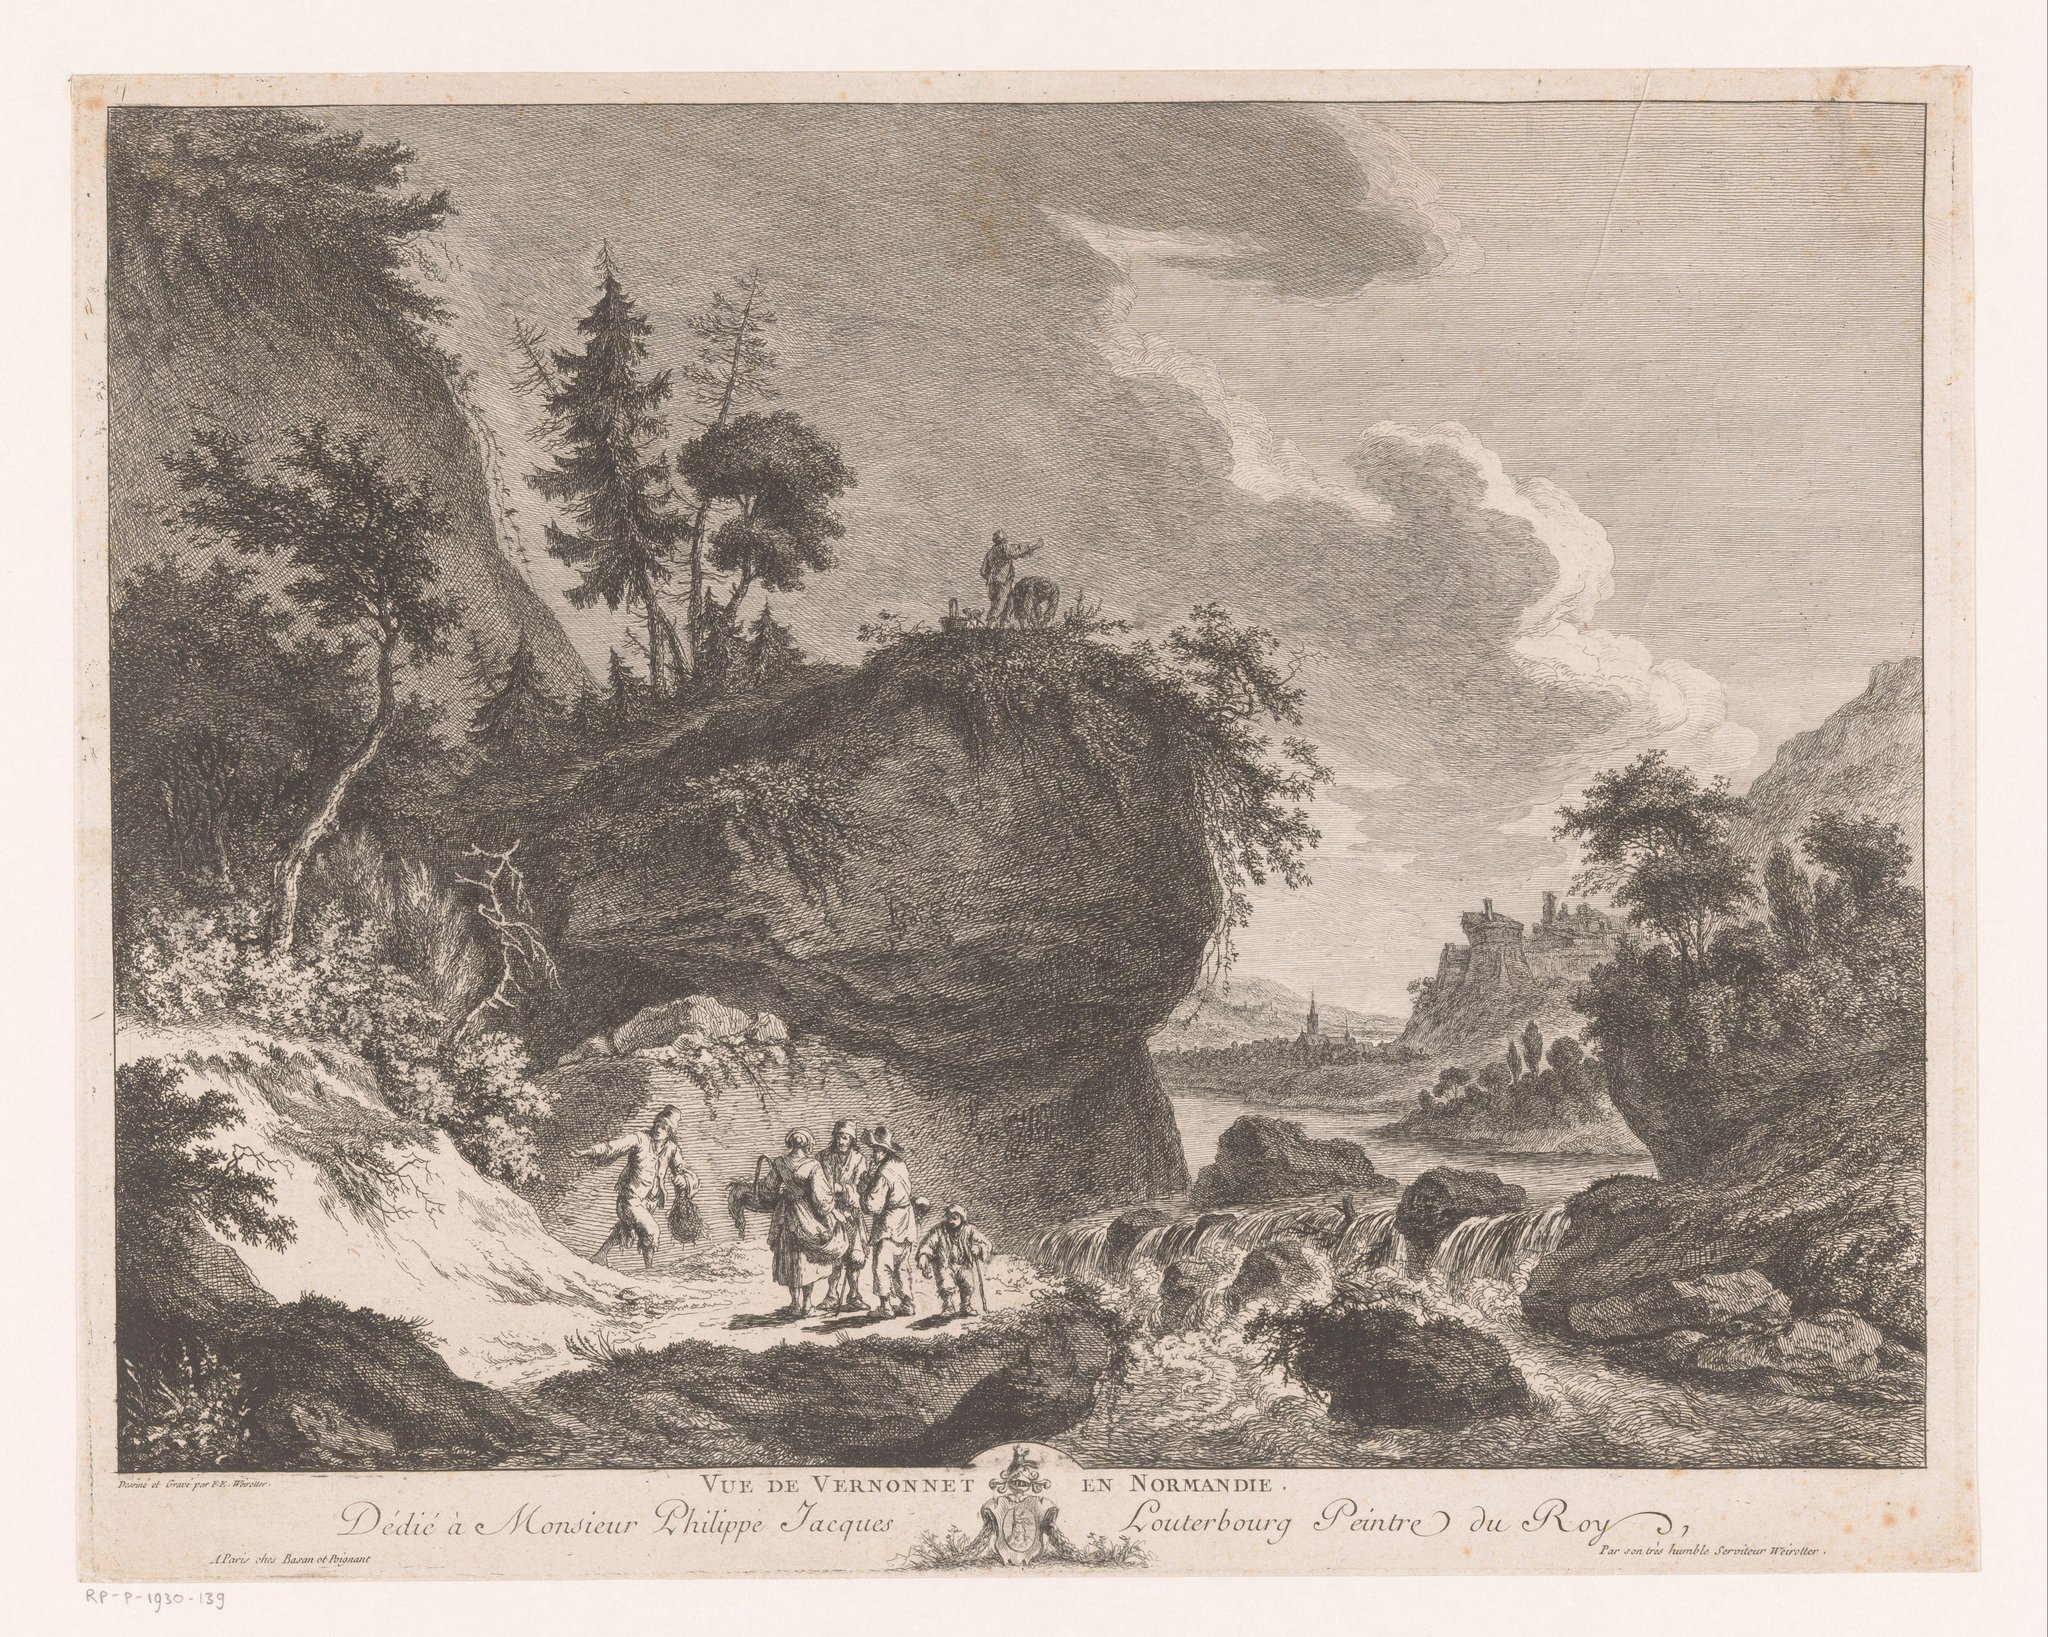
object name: print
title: Vue de Vernonnet en Normandie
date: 1760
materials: paper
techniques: etching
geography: paris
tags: river, waterfall, trees: pine, rocks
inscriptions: collector's mark: Lugt 2233